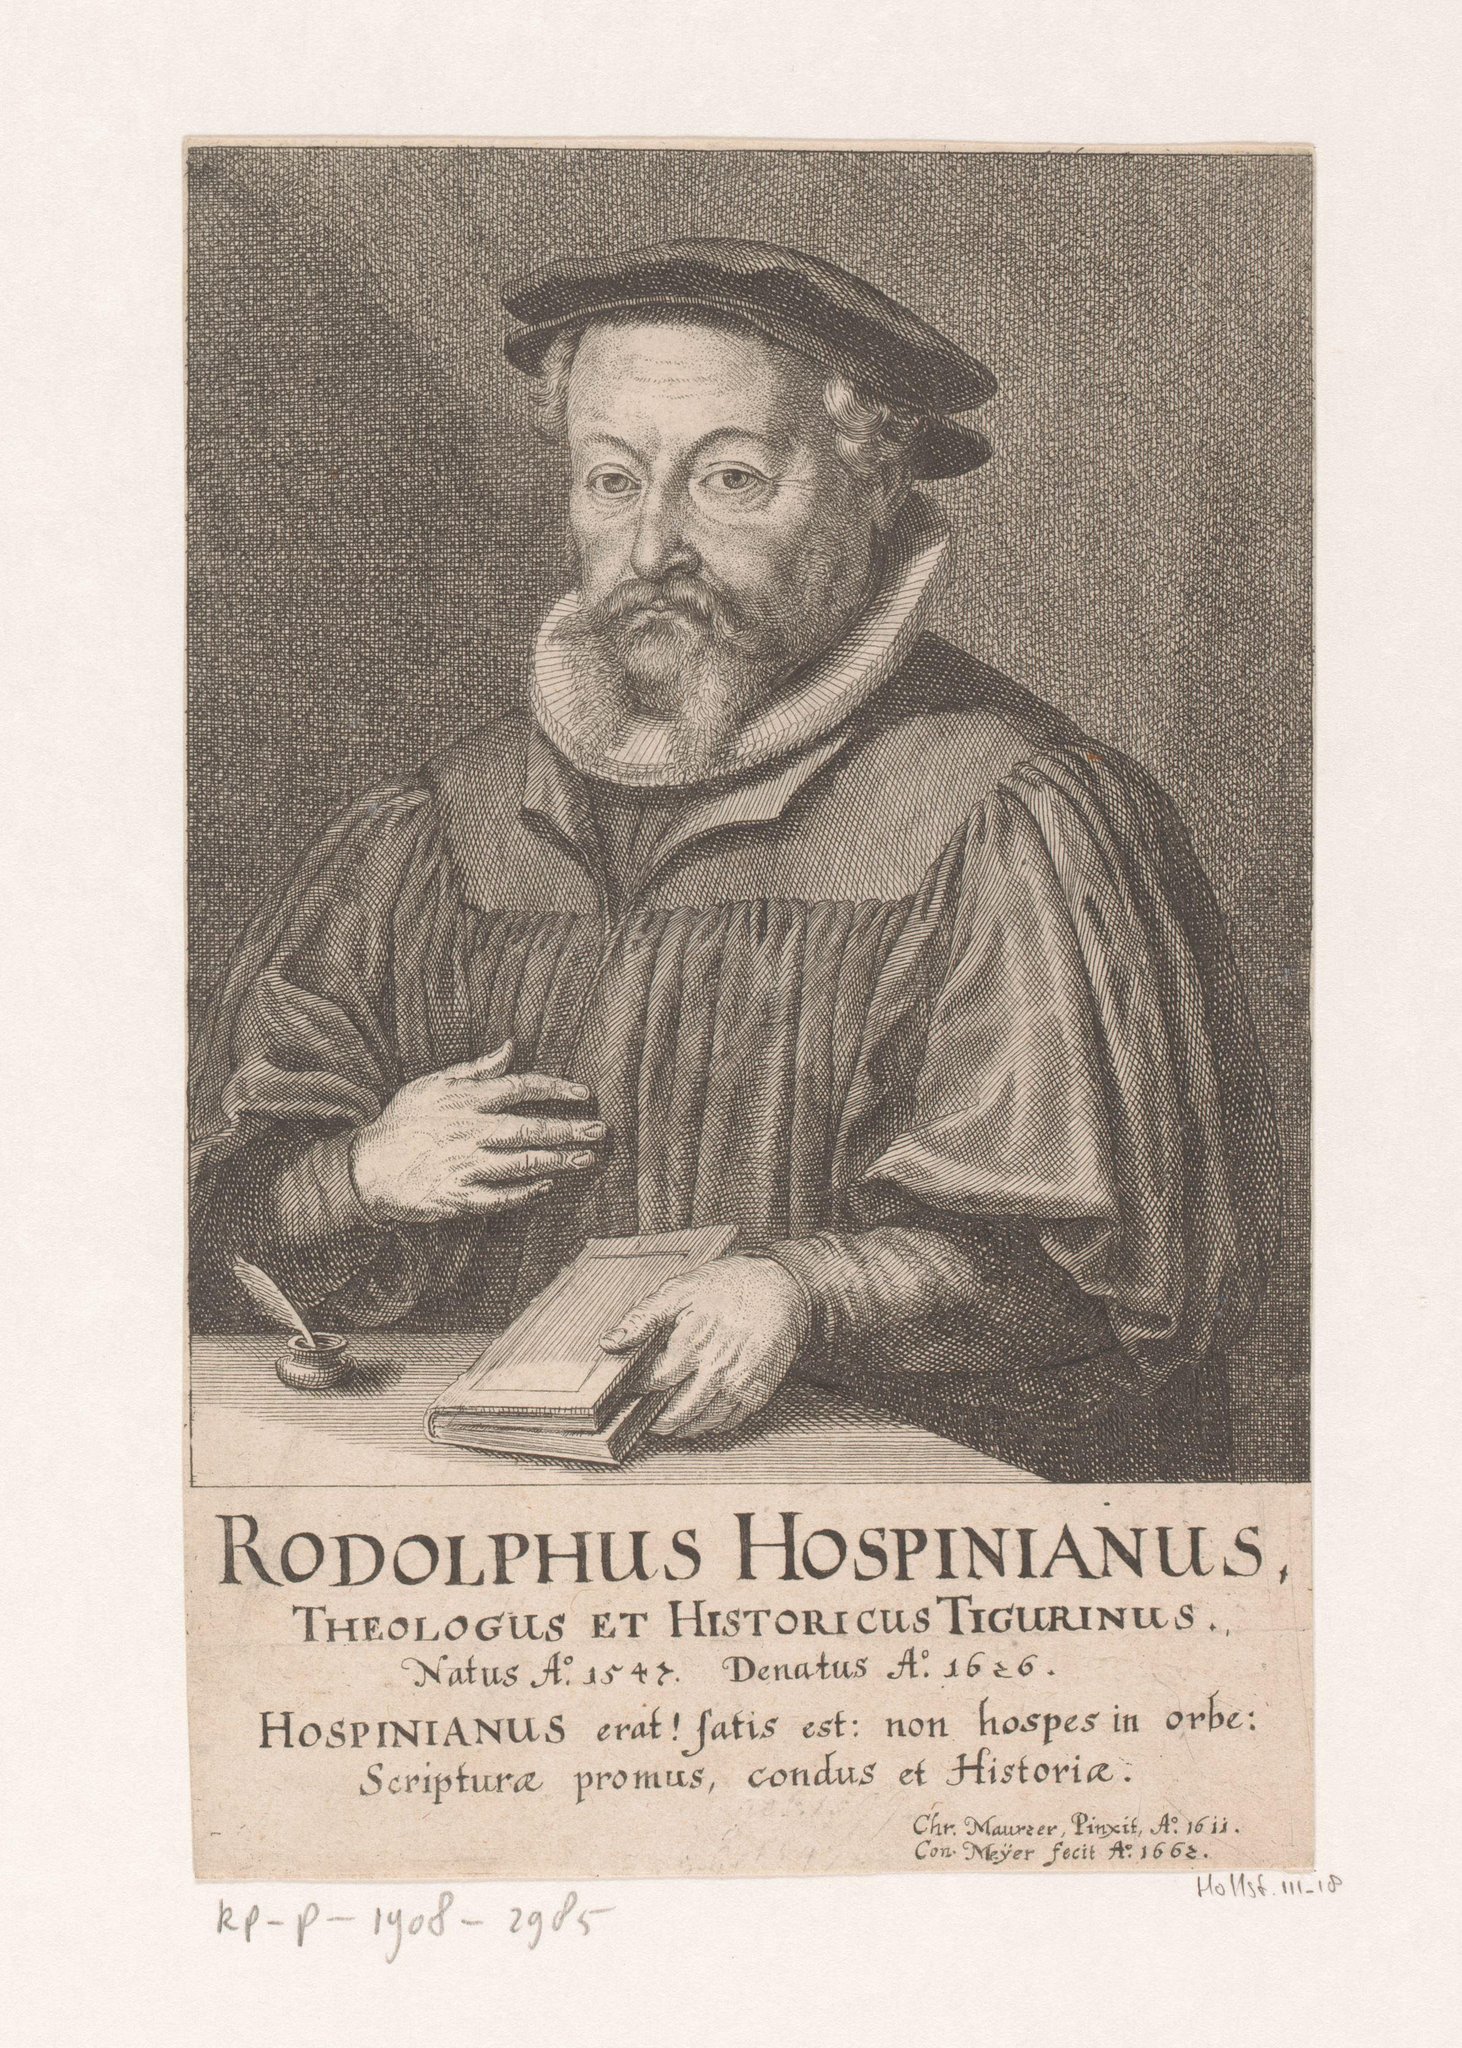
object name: print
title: Portretten van priesters van Zürich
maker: conrad meyer (i)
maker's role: painter, print maker, publisher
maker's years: 1618-1689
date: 1662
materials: paper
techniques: engraving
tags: theologian, historical persons, book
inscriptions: collector's mark: Lugt 2228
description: Onderdeel van een serie van 62 portretten van priesters en theologen van Zürich. Zie Hollstein German 111, 1-41.